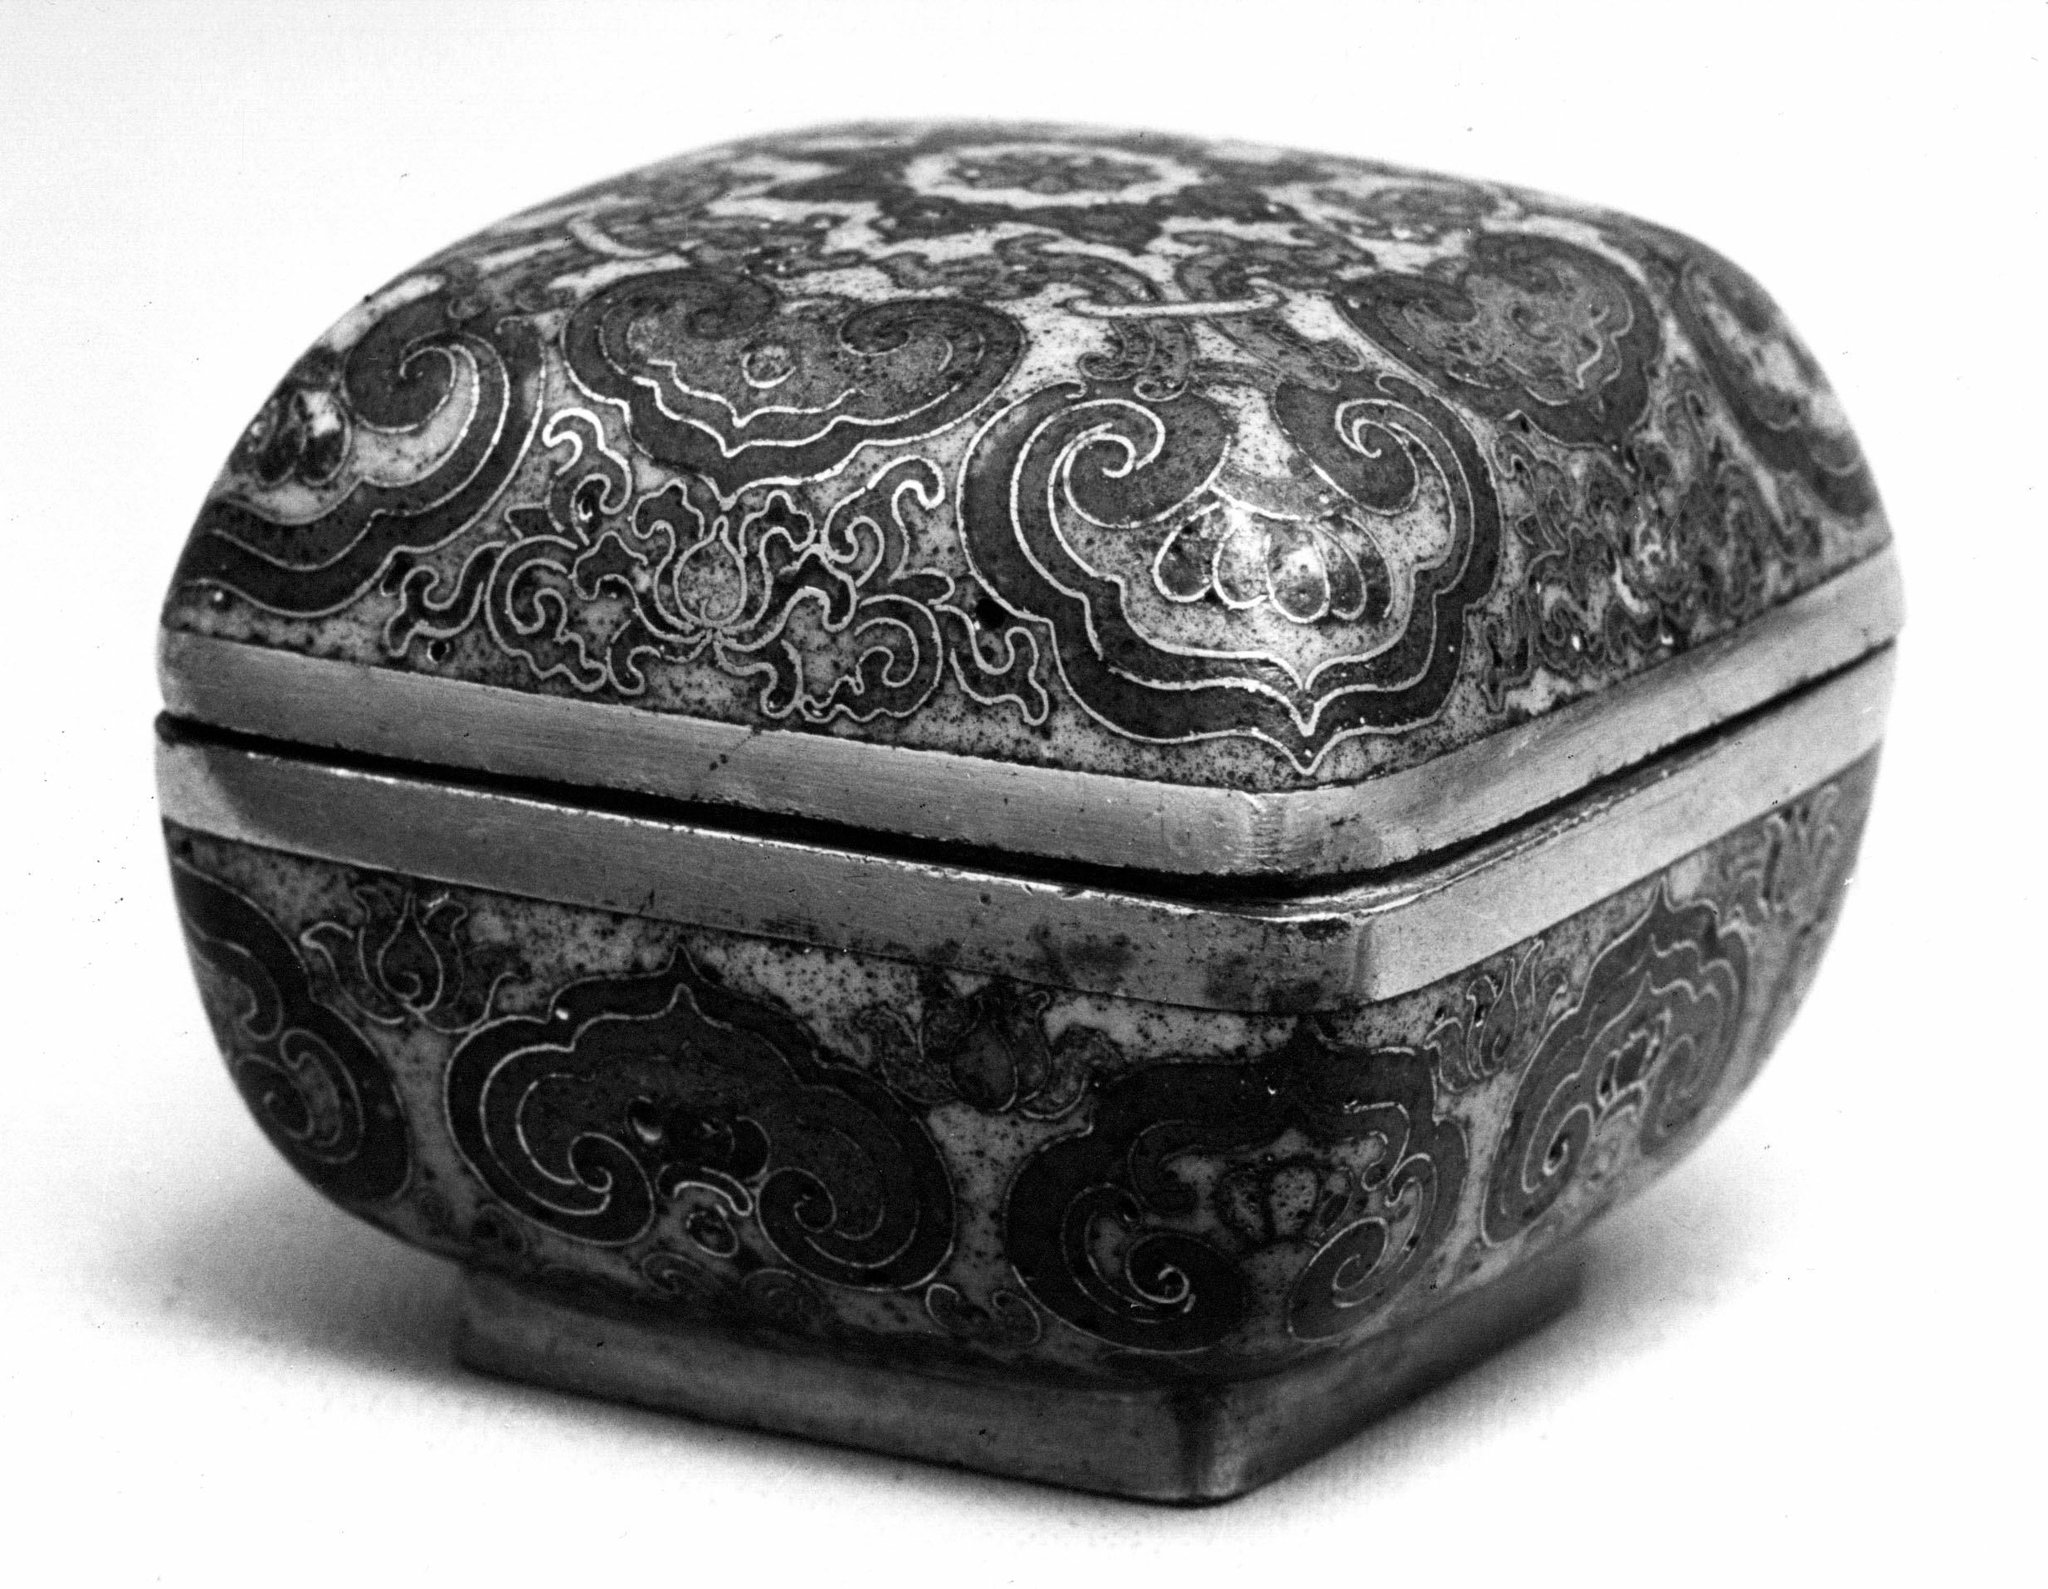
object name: covered box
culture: chinese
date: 1667-1733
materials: enamel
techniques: enamel